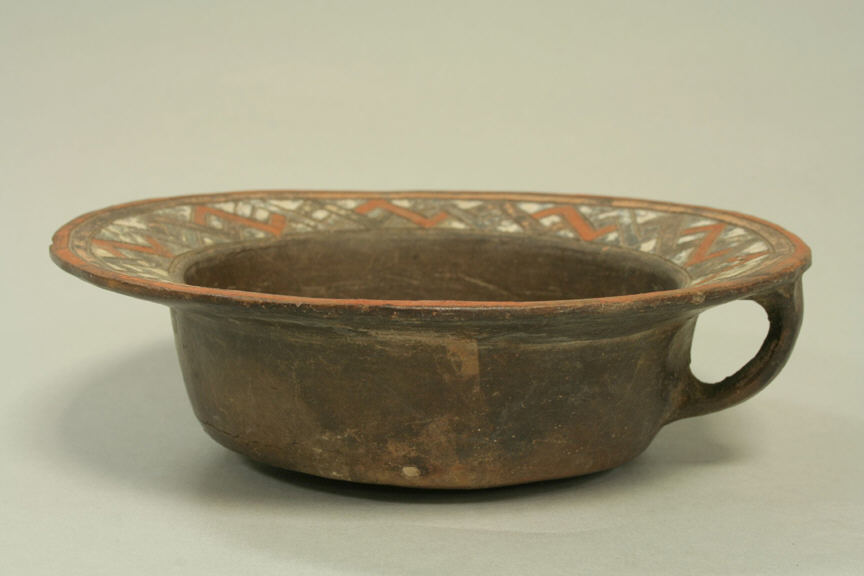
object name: bowl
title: Bowl with Flat Rim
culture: paracas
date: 500-201 BCE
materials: ceramic, pigment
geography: peru